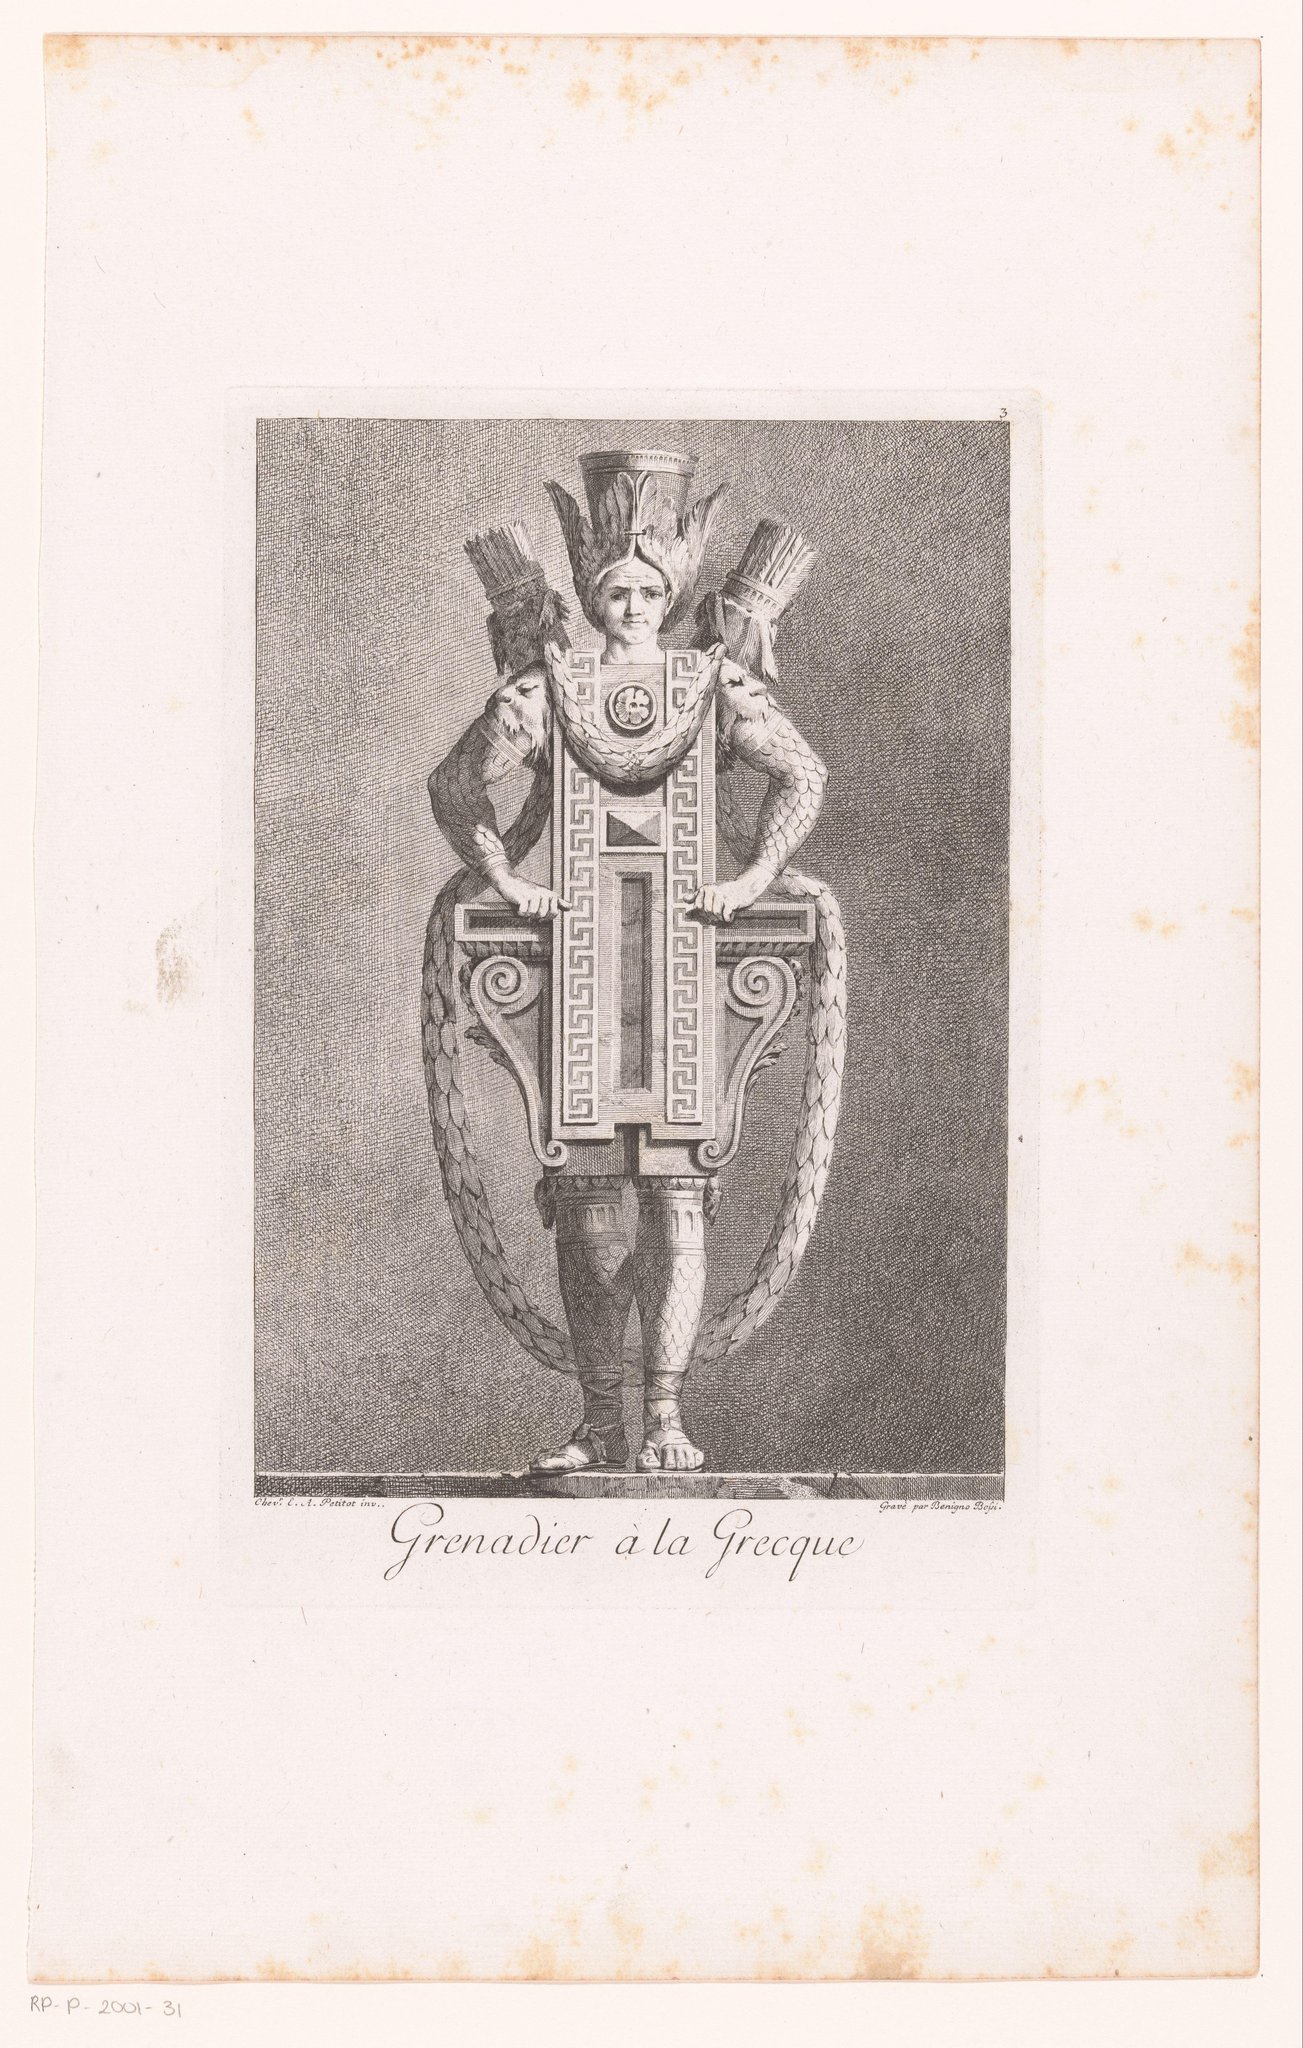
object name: print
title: Mascarade A La Grecque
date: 1771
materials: paper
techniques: etching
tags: europeans, the soldier; the soldier's life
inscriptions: collector's mark: Lugt 2228, collector's mark: Lugt 2760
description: Een staande man met rechthoekig lijf en consoles bij de heupen. Over zijn schouders hangt een guirlande. Op zijn rug draagt hij twee pijlenkokers en op zijn hoofd een hoofddeksel met veren.